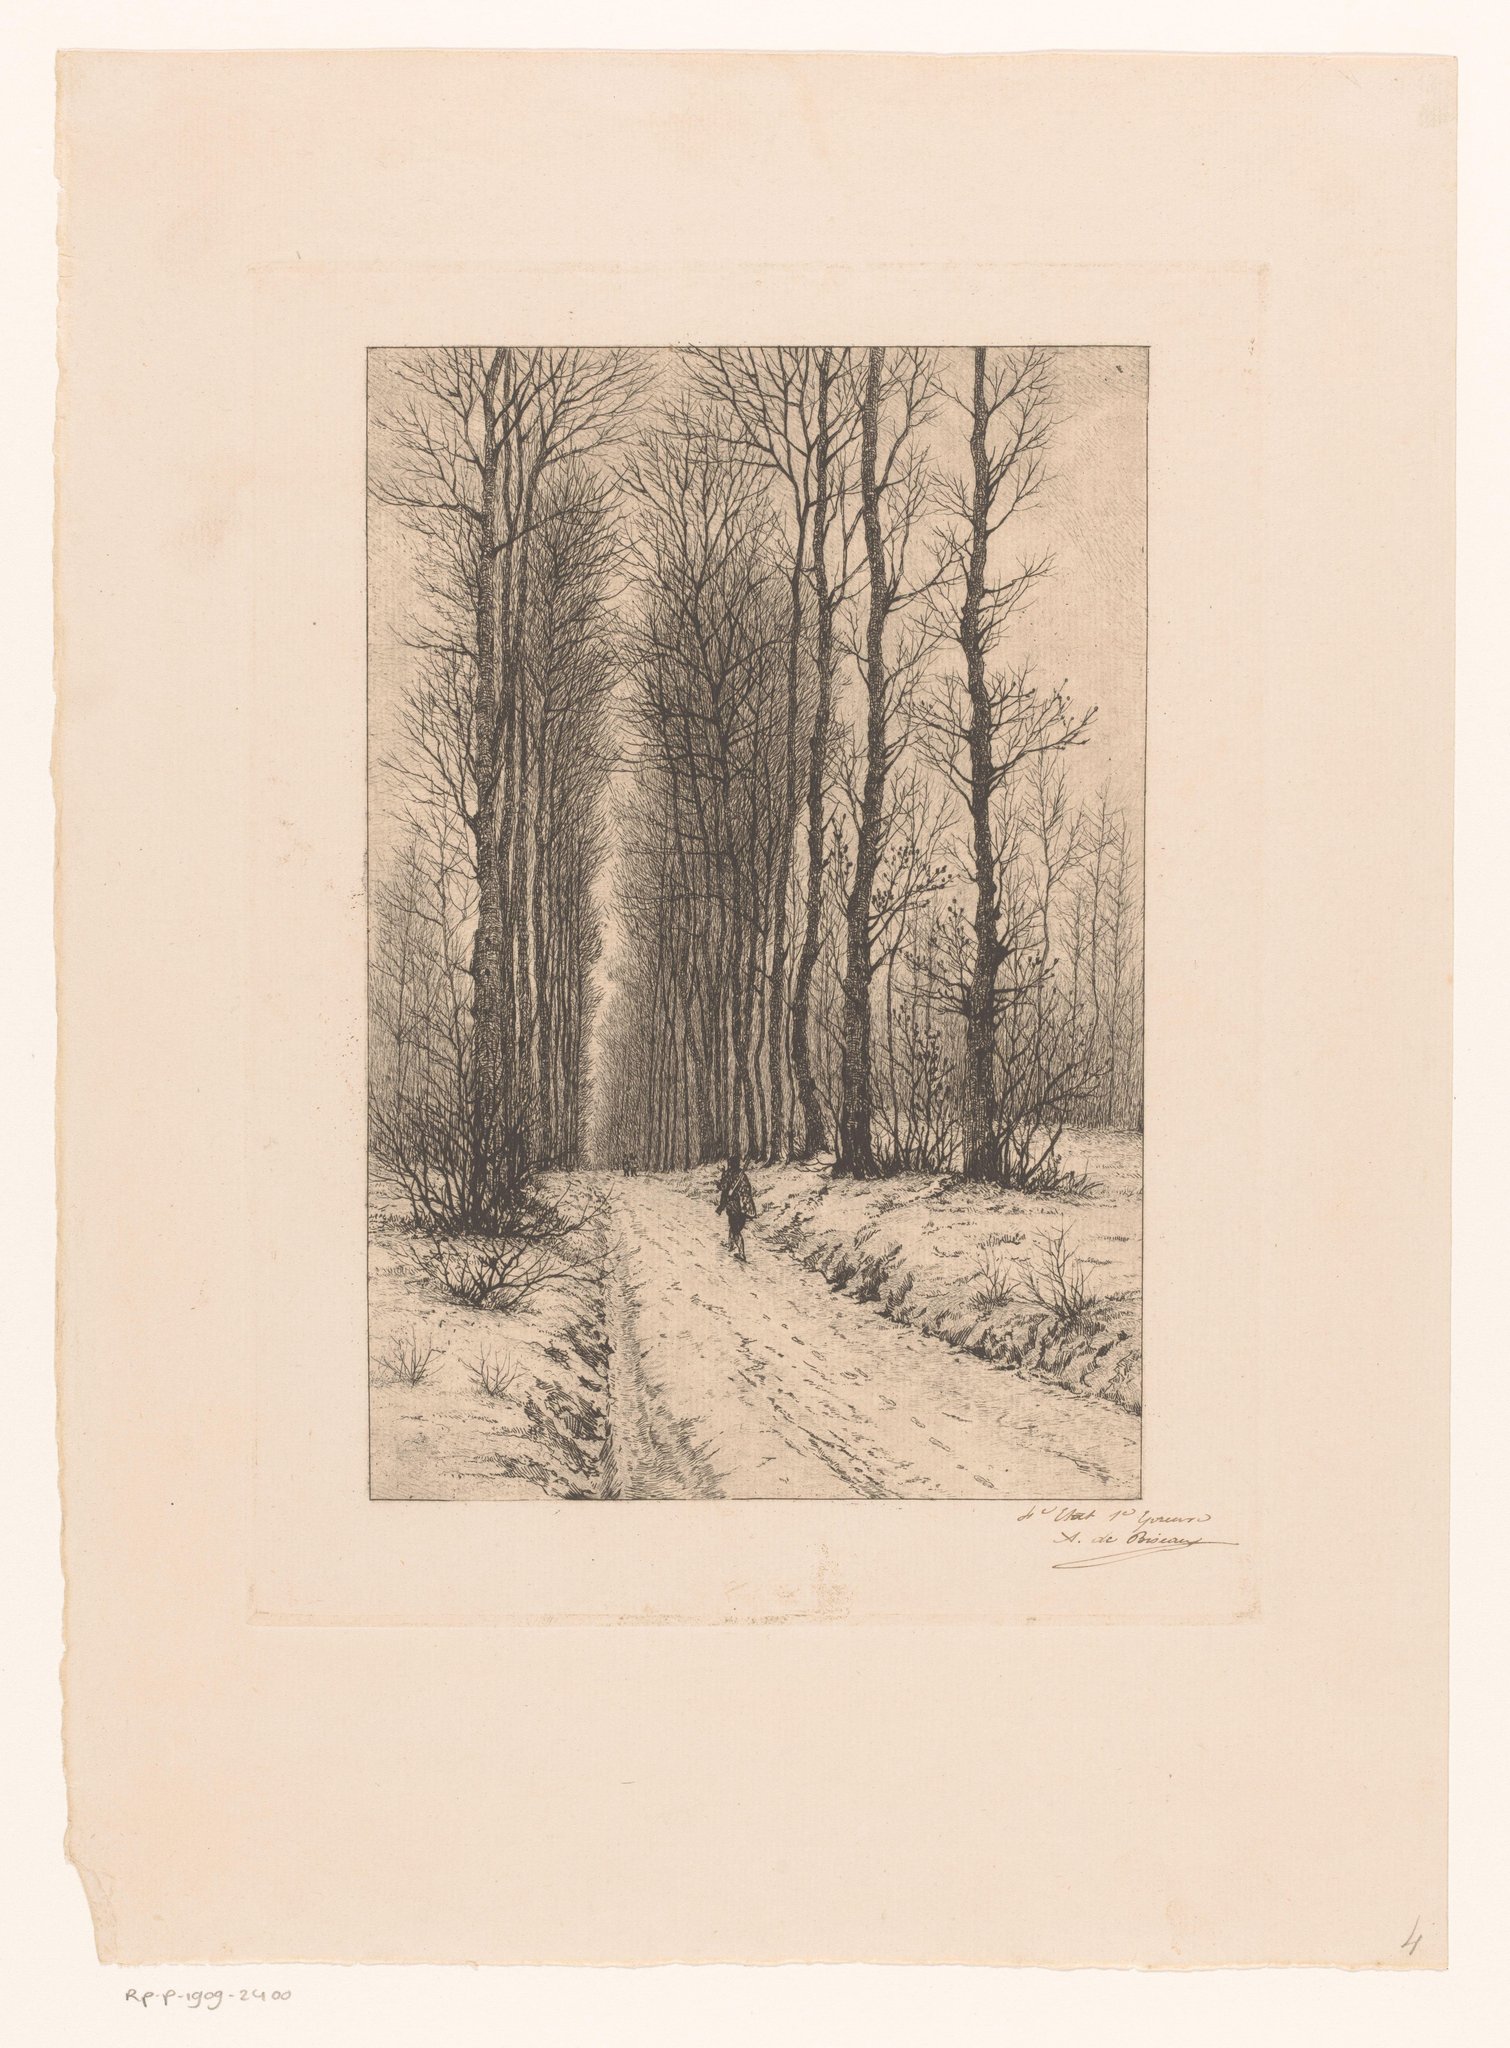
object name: print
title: Besneeuwd bospad met jager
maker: aristide de biseau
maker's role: print maker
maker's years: 1844-1883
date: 1854-1883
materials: paper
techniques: drypoint, etching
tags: hunter, forest, wood, winter landscape; landscape symbolizing winter (the four seasons of the year), snow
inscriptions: inscription: ‘4e Etat 1e Epreuve’, collector's mark: Lugt 2228